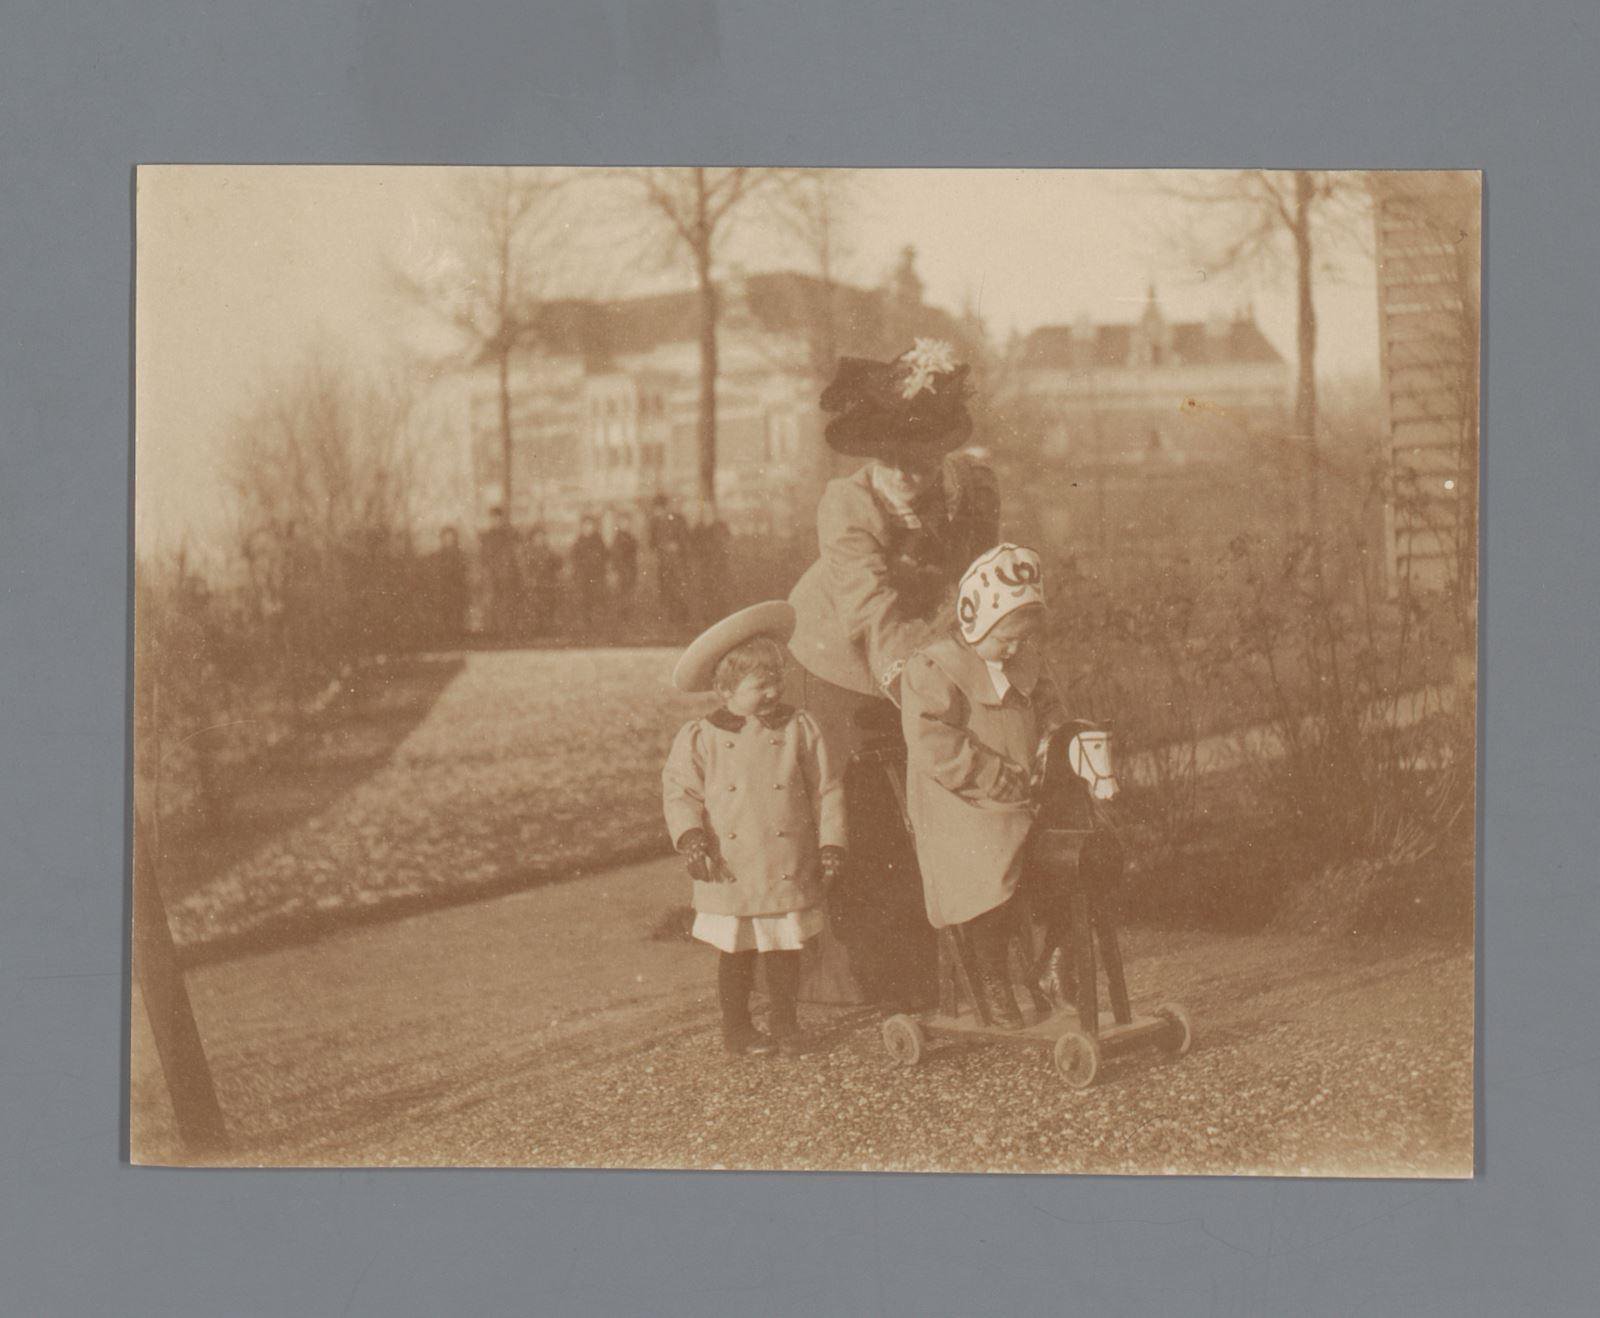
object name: photograph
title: Jennigje Hendrika Jacoba Jonker loopt met twee kinderen op straat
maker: johannes diderik van der waals (1873-1971)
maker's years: 1873-1971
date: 1906-1907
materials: photographic support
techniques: collodion silver print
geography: groningen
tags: hobby-horse, child, historical persons